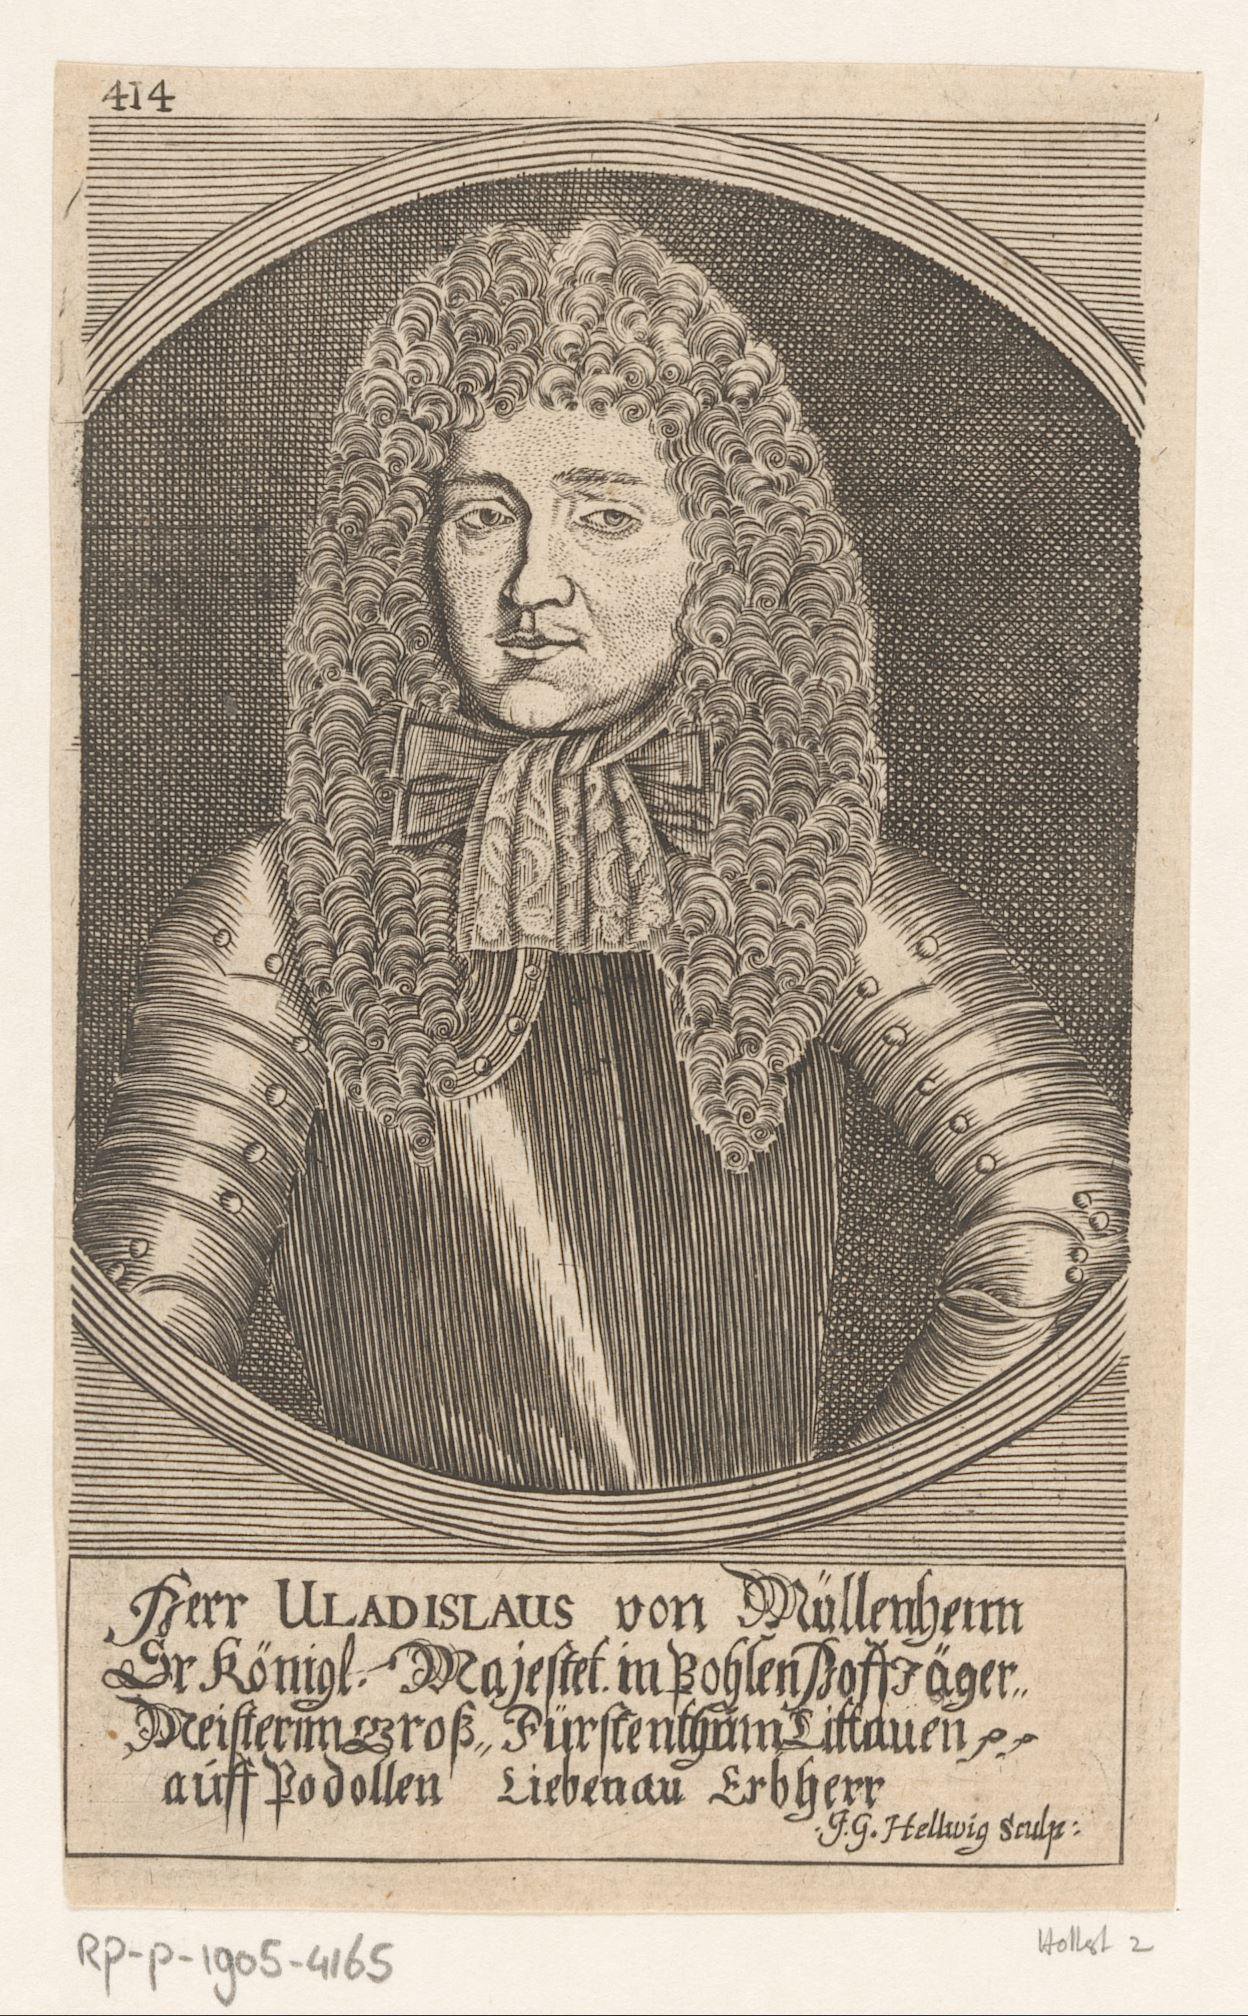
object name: print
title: Portret van Wladislaus von Müllenheim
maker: johann georg hellwig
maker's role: print maker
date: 1694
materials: paper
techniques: engraving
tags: armour, historical persons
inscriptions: collector's mark: Lugt 2228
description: Prent gebruikt voor: Kongehl, Michael. Immergrünender Cypressen-Hayn (...). Danzig: Martin Hallervord, 1694.